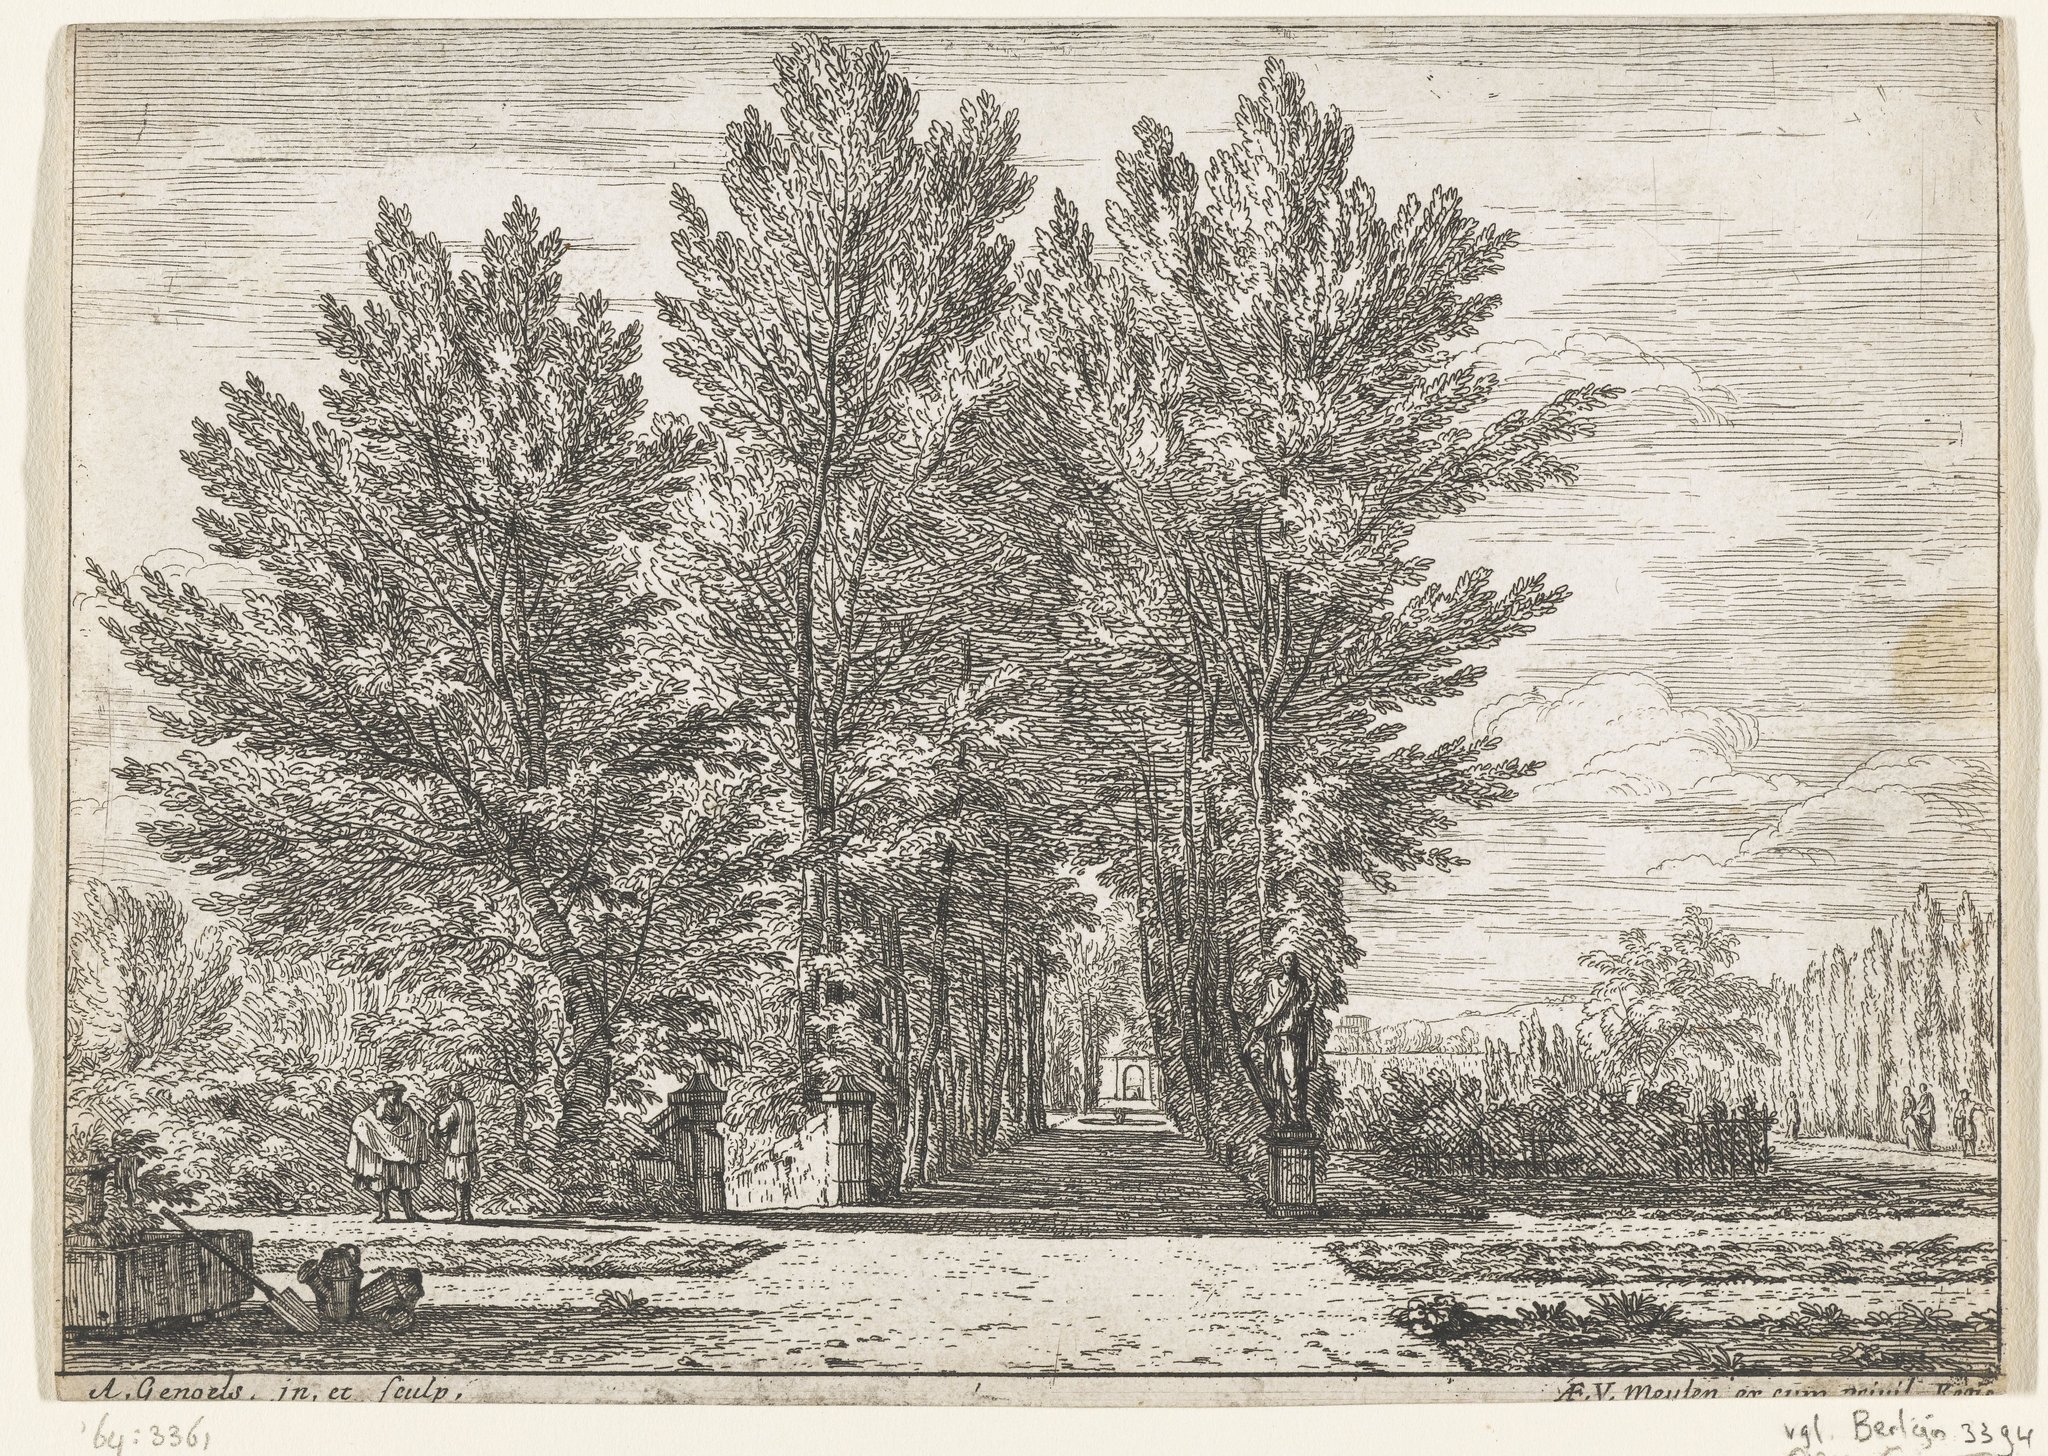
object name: print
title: Gezicht op een schaduwrijke laan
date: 1650-1690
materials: paper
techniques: etching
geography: paris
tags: garden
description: Rechts een parterre. Uit serie van 6 bladen.